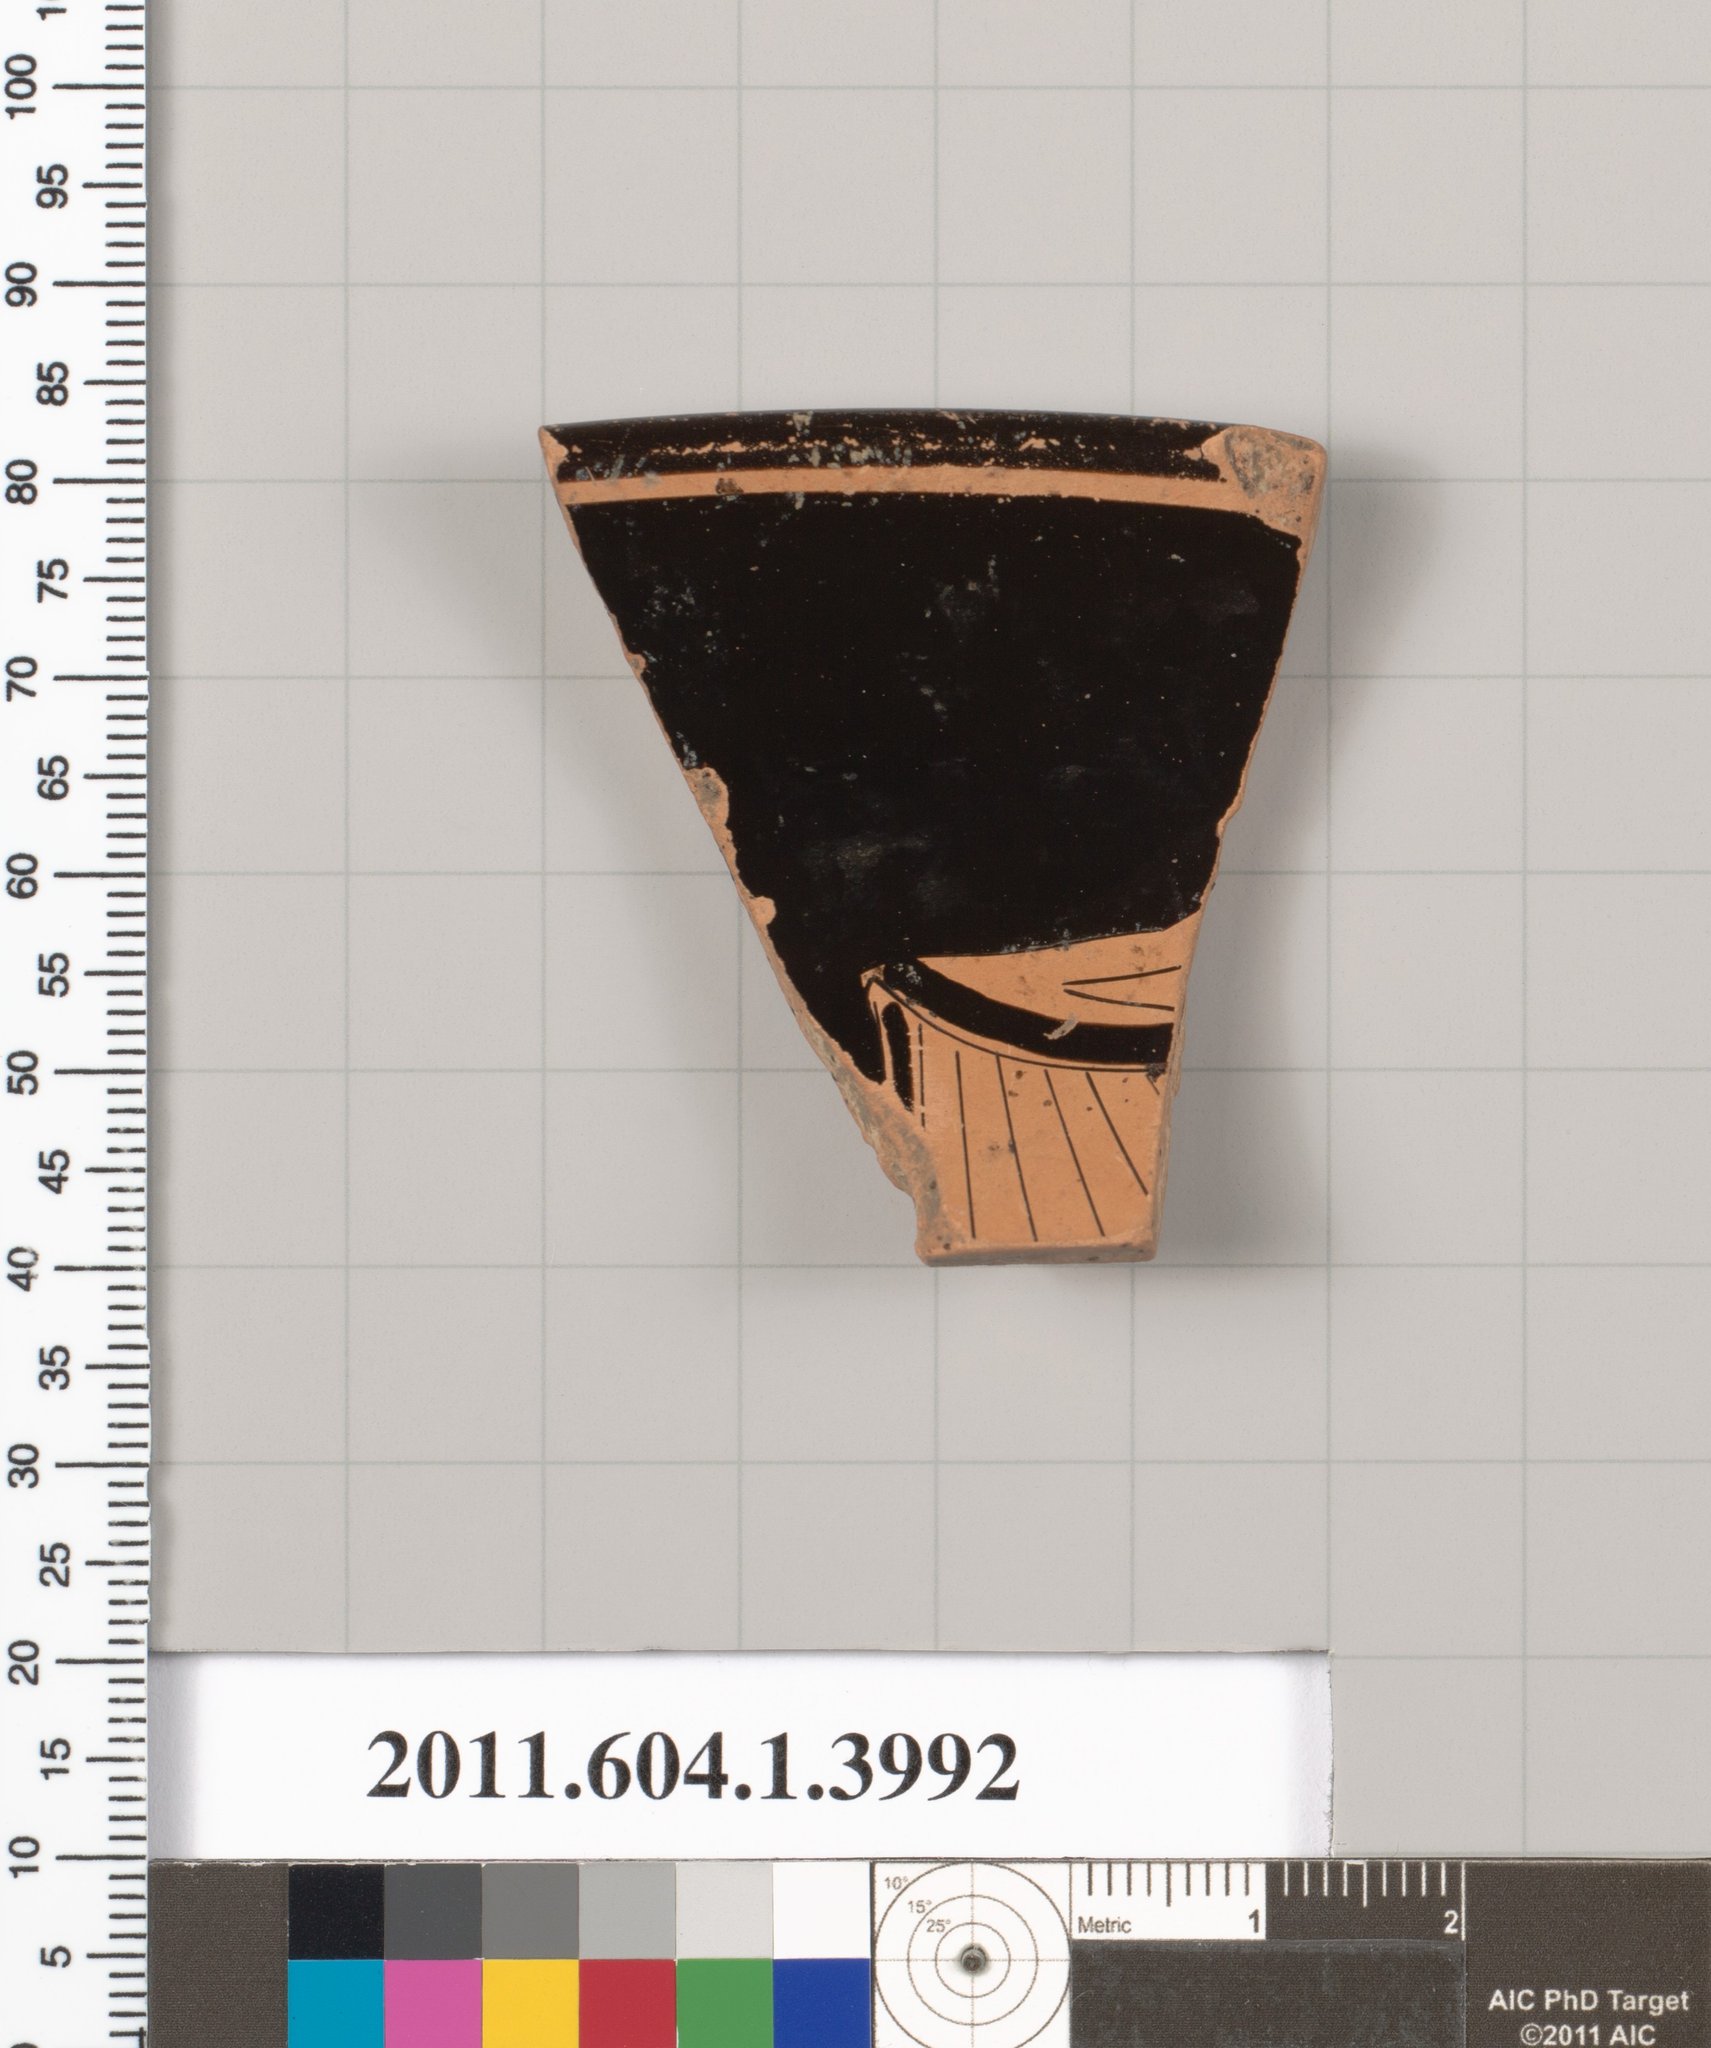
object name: kylix fragment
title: Terracotta rim fragment of a kylix (drinking cup)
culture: greek, attic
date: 490-470 BCE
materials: terracotta